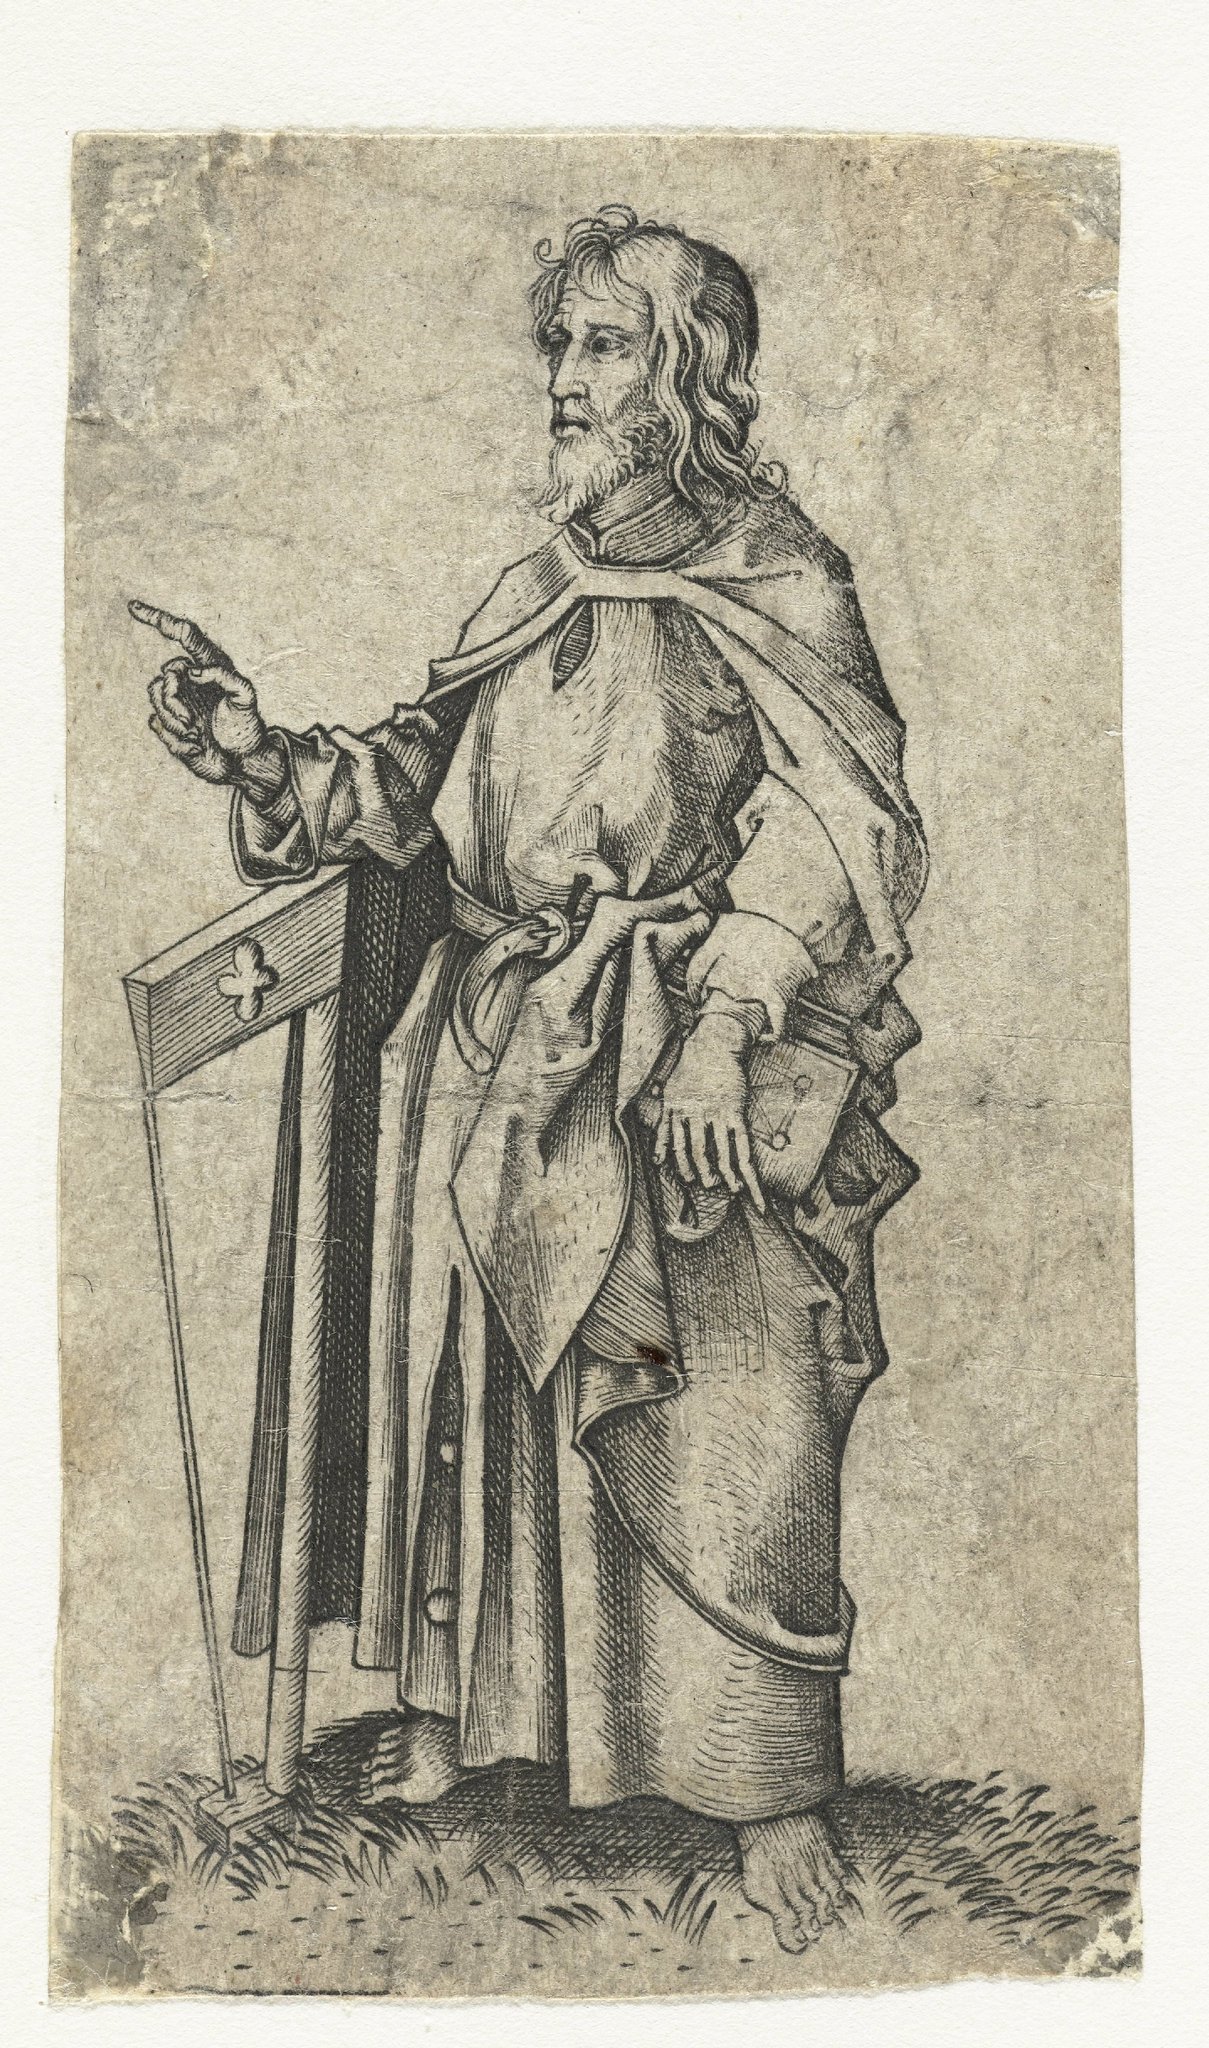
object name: print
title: De twaalf apostelen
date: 1475-1491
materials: paper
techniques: engraving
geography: bocholt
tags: the apostle jude thaddaeus; possible attributes: book, club, halberd, scroll, the apostle james the less, first bishop of jerusalem; possible attributes: book, fuller's club, scroll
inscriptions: collector's mark: Lugt 2228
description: De apostel Jakobus de Mindere (Judas Thaddeüs?), ten voeten uit, met een boek in de hand, steunend op een hoedenmakersboog (?). Deze prent is onderdeel van een serie van twaalf portretten van de apostelen, spiegelbeeldige kopieën naar prenten van Martin Schongauer.